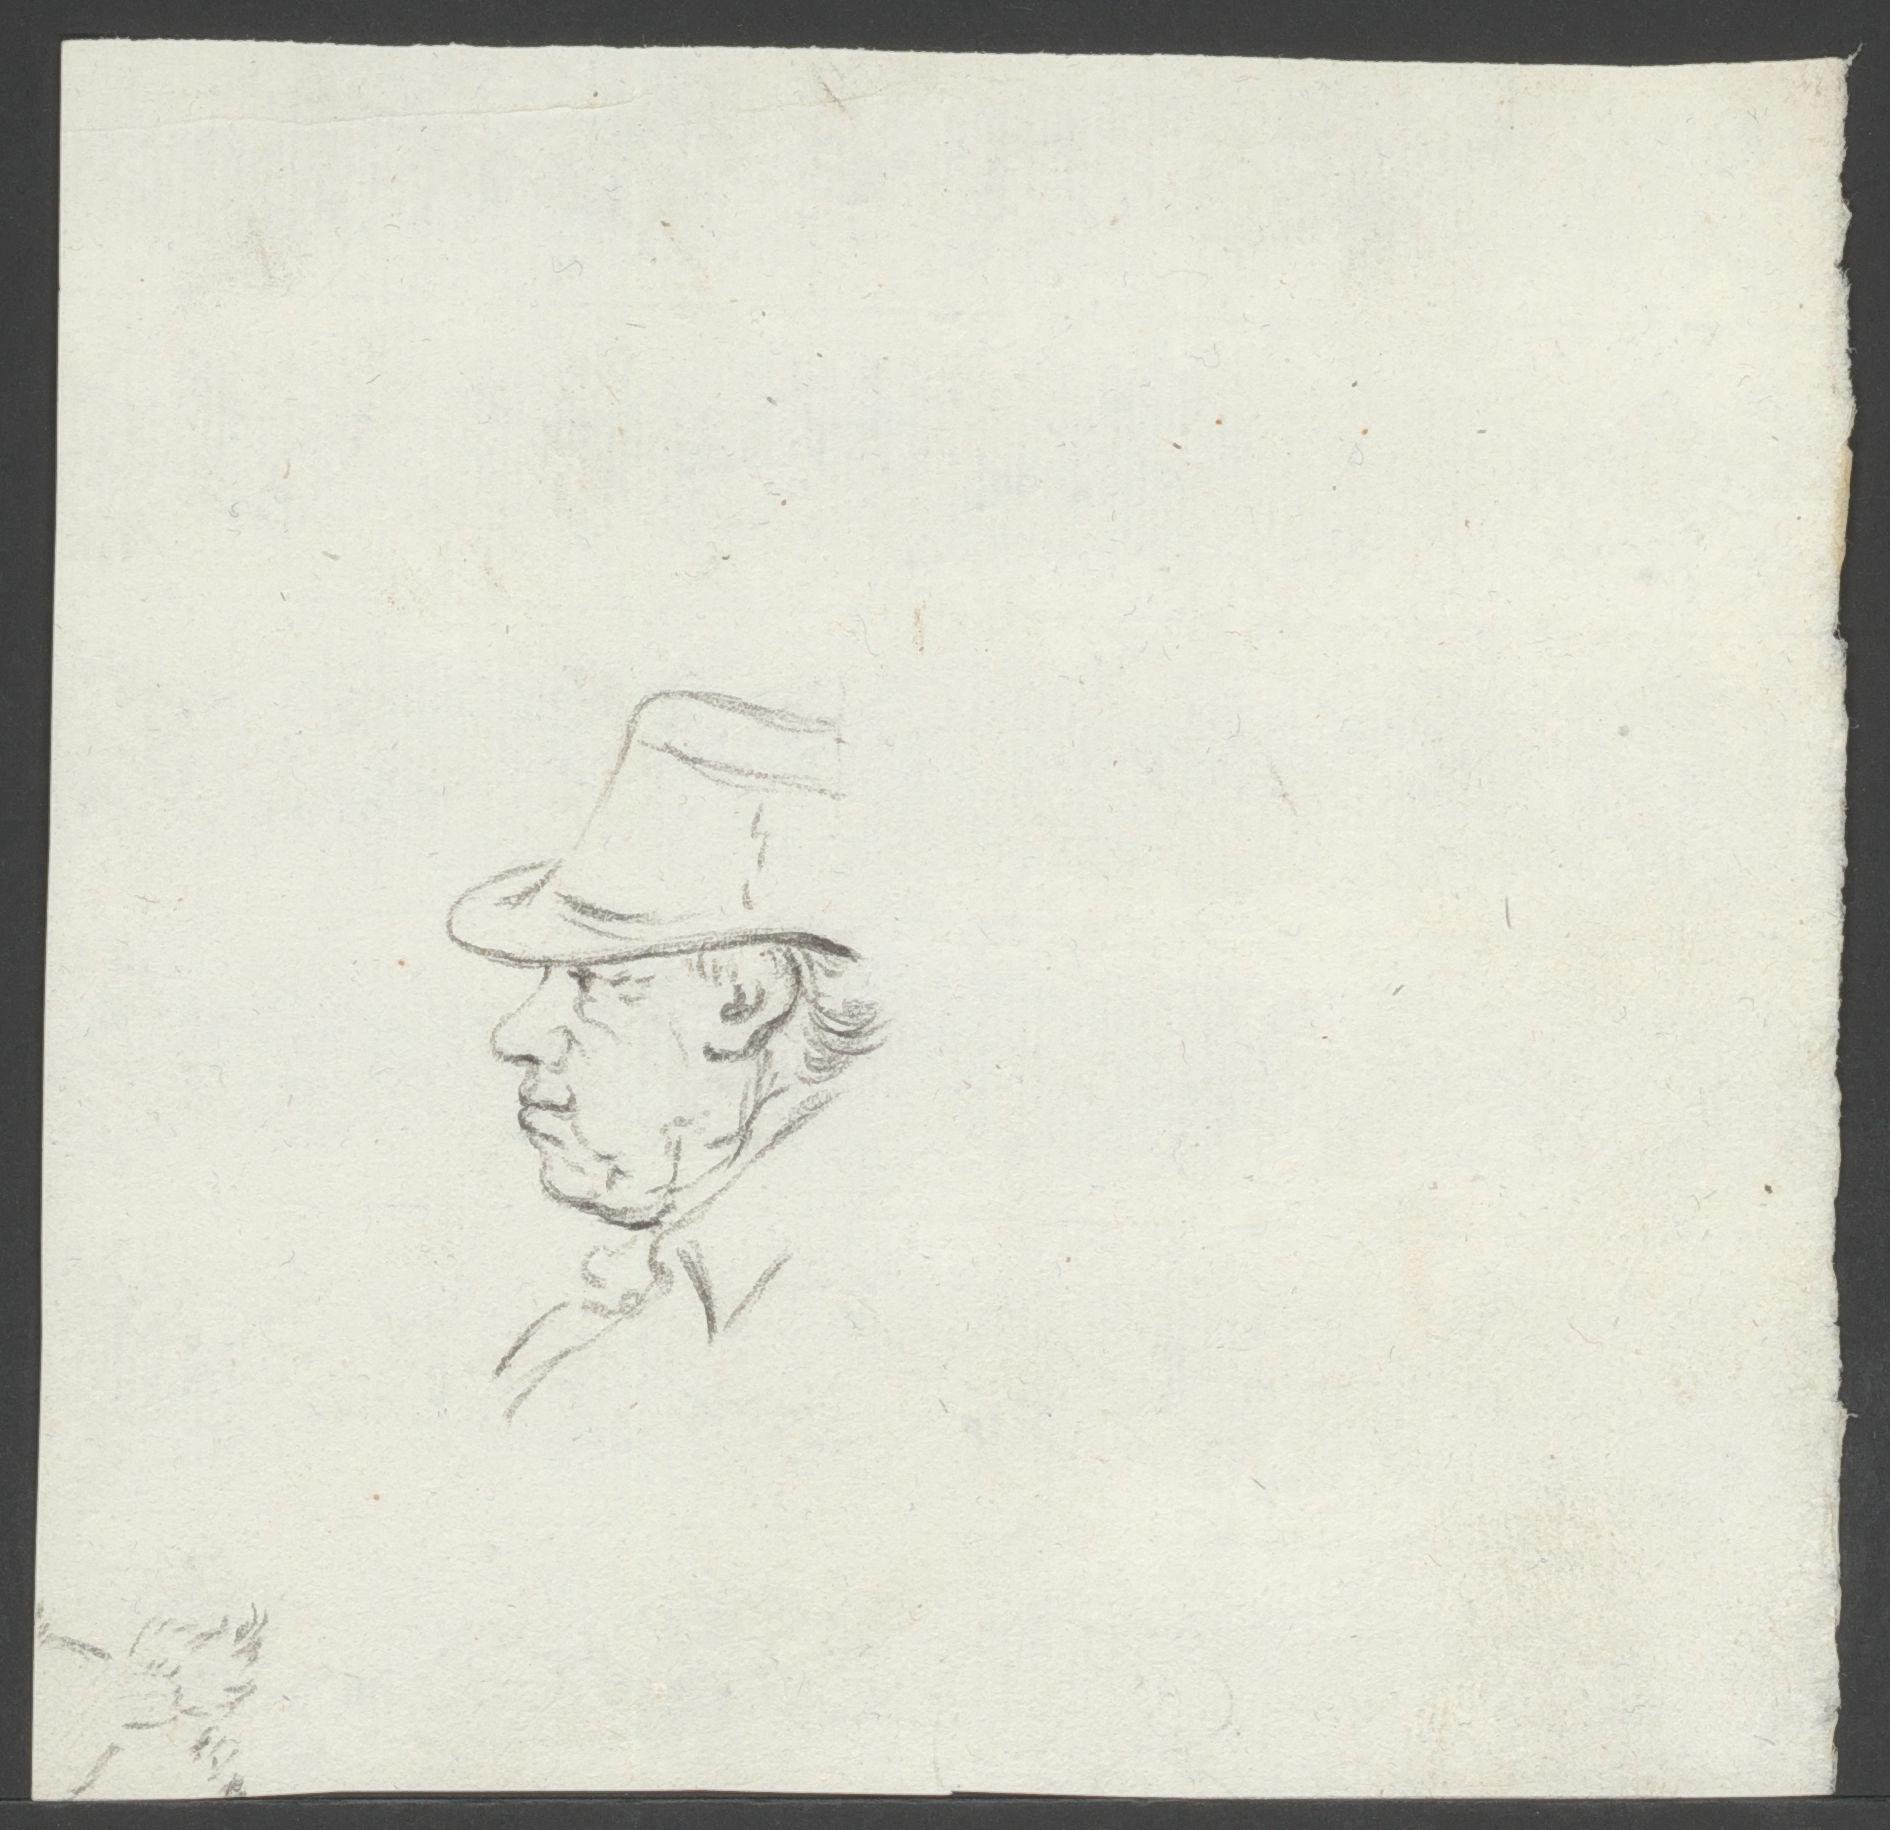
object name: drawing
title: Man met hoed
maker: jean bernard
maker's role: draughtsman, print maker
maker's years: 1765-1833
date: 1775-1833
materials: chalk, paper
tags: head (human) (+ sideview, profile), old man, head-gear: hat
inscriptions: stamp, collector's mark: Lugt 1641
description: Onderwerpsrubrieken binnen de Atlas Zeden en Gewoonten: Schoone kunsten, Schilderkunst, Tekeningen.